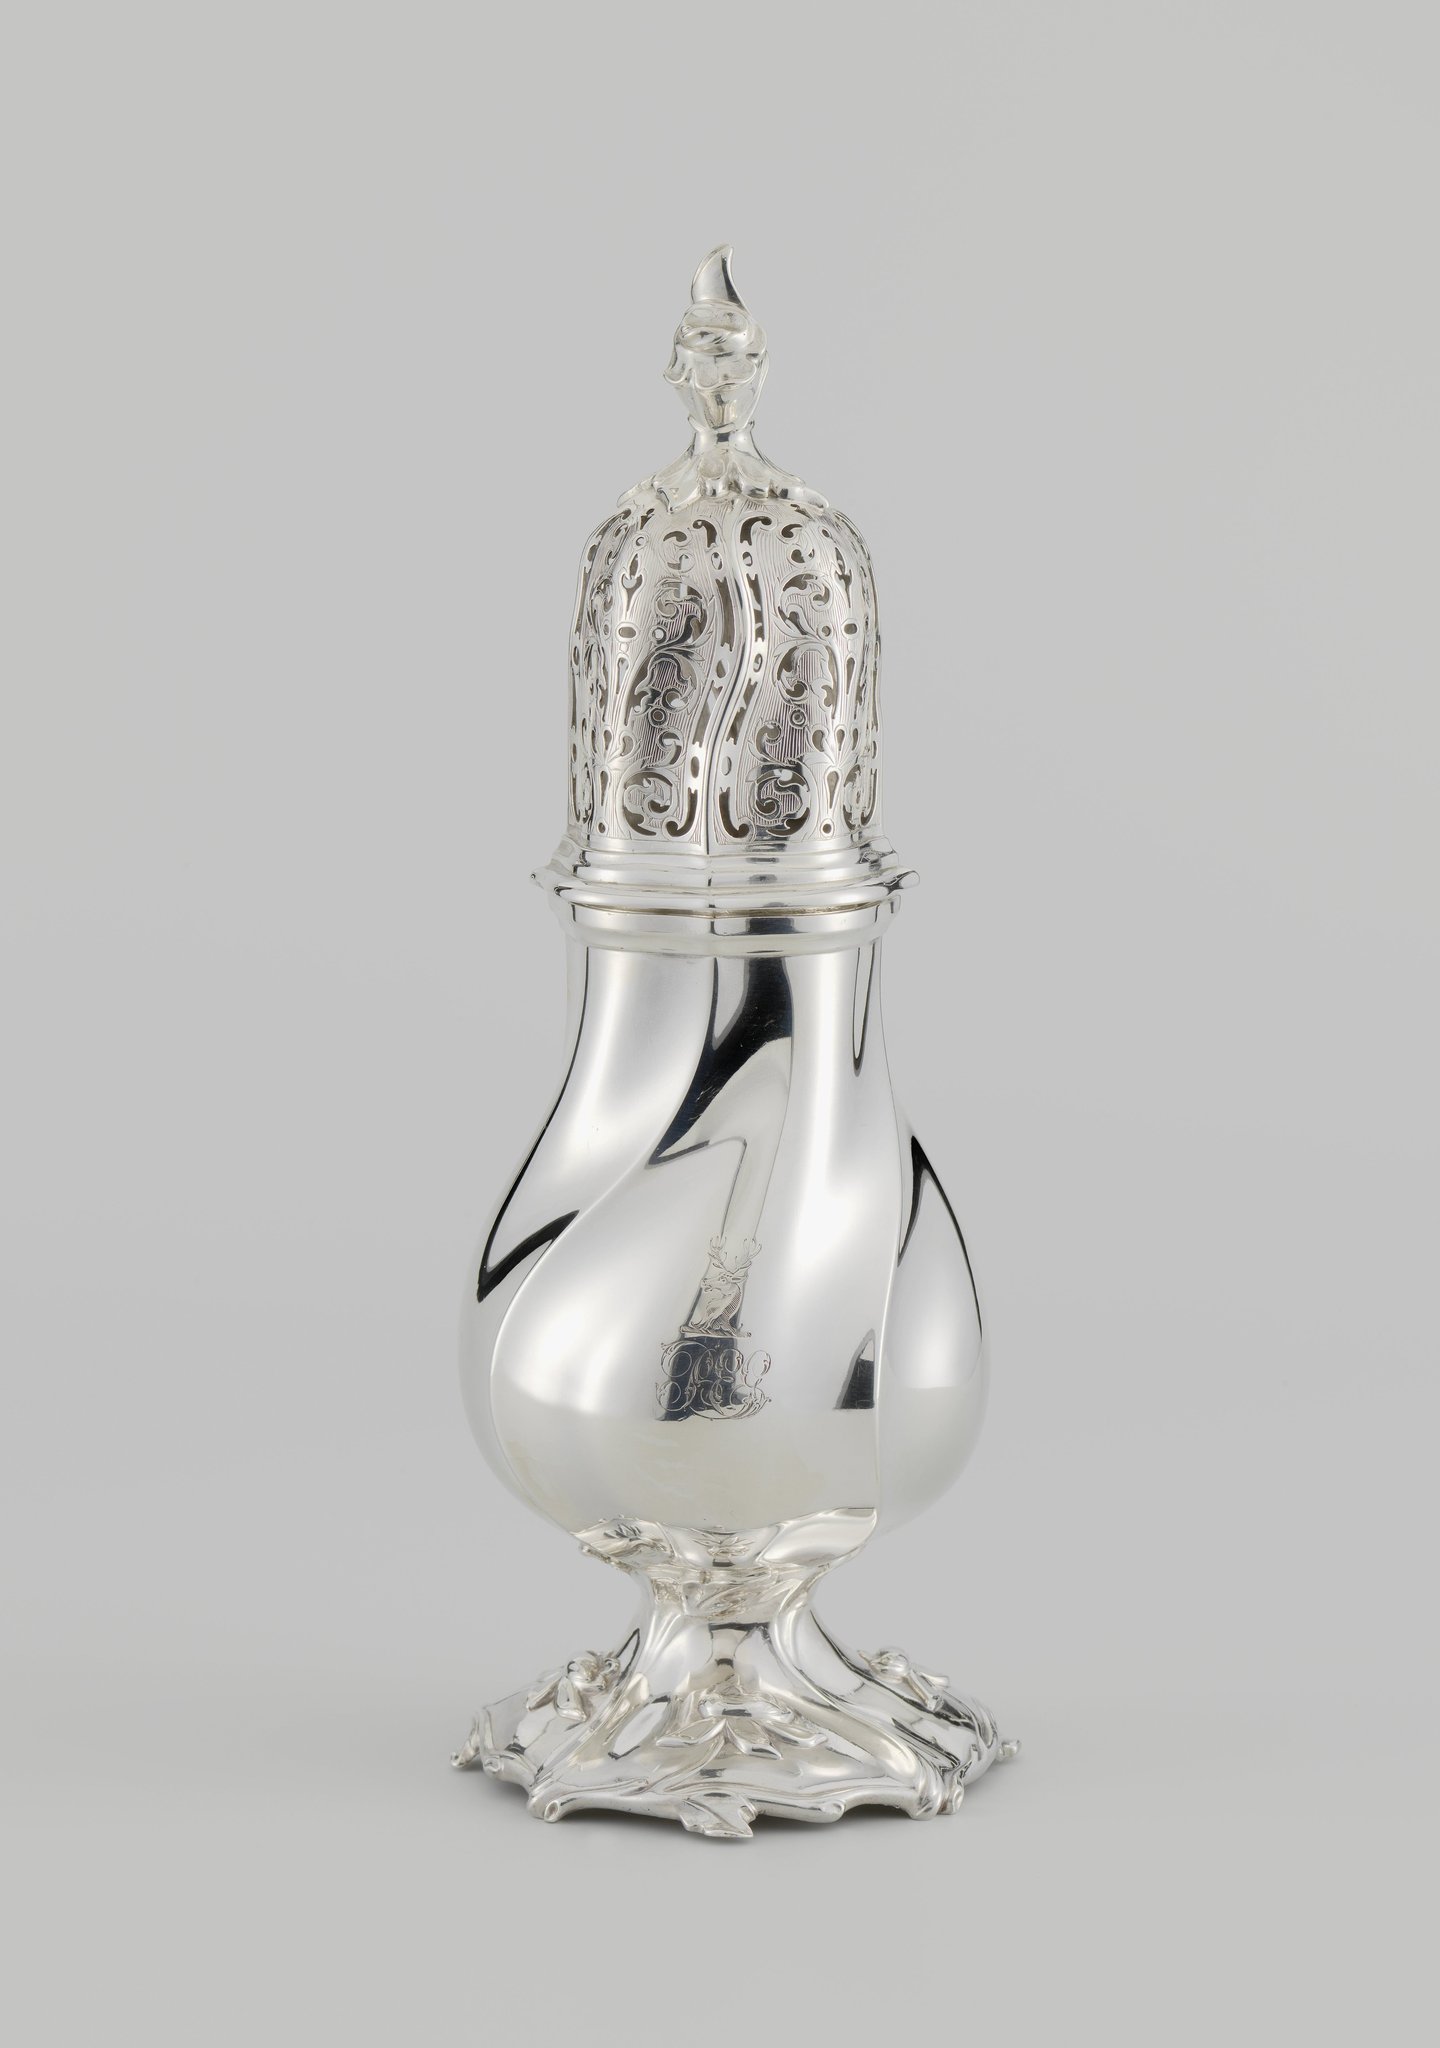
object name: strooibus, strooier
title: Strooibus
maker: pieter van der kruyf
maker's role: silversmith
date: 1768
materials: silver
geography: the hague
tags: flowers ~ ornament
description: Wine cooler. Silver. Den Haag, 1768, by Gregorius van der Toorn. Given by the Commissie voor Fotoverkoop and the Vereniging Rembrandt, 1974. Four candlesticks. Silver. Zwolle, 1770, by Cornelis Wilhelmus Rensing. Given by Count J.A.Z. van Rechteren Limpurg, 1937. Castor. Silver. Den Haag, 1768, by Pieter Kersbergen.